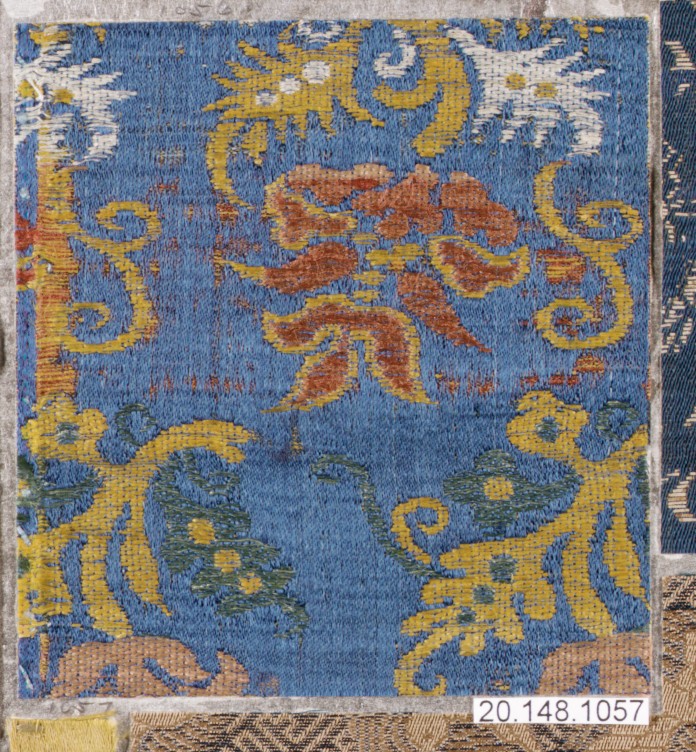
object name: piece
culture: japanese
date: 1701-1800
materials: silk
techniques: compound weave